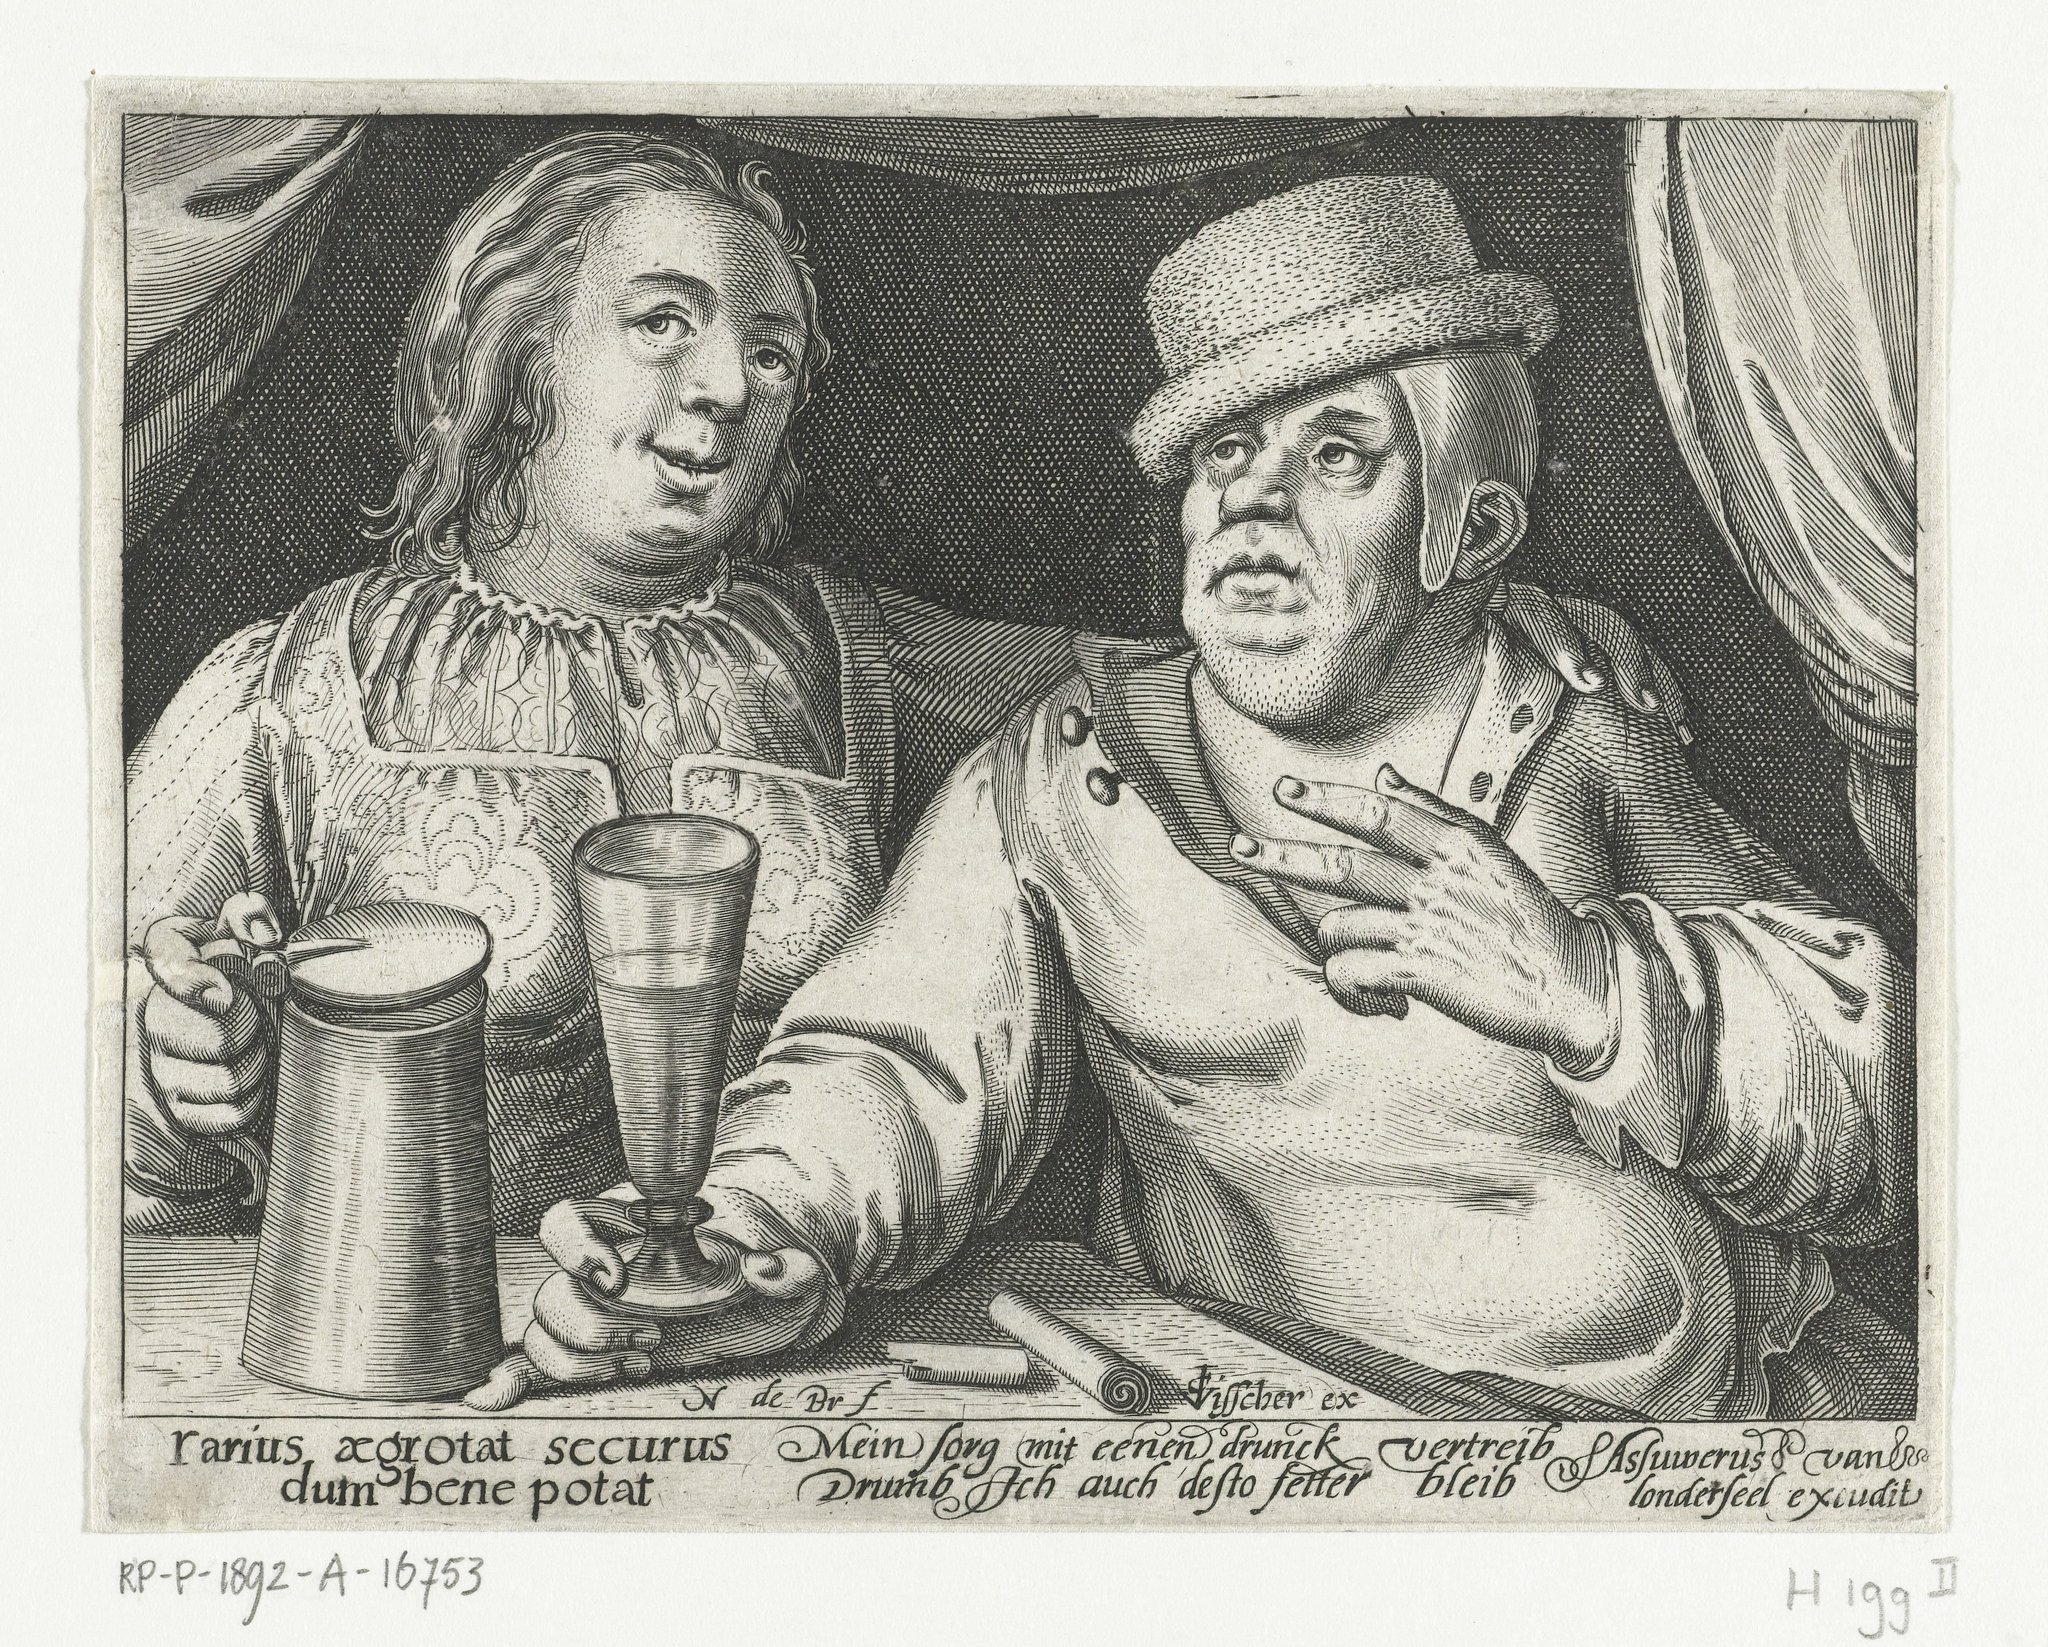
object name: print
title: Drinkende man en vrouw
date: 1581-1656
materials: paper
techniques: engraving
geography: amsterdam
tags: drinking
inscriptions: collector's mark: Lugt 2228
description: Een man en vrouw zitten bij een tafel, hij met een glas in zijn hand, zij met een bierkan. Volgens het Duitse vers in de marge onder drinken zij hun zorgen weg en leidt deze drankzucht tot overgewicht. Het vers wordt herhaald in Latijn.